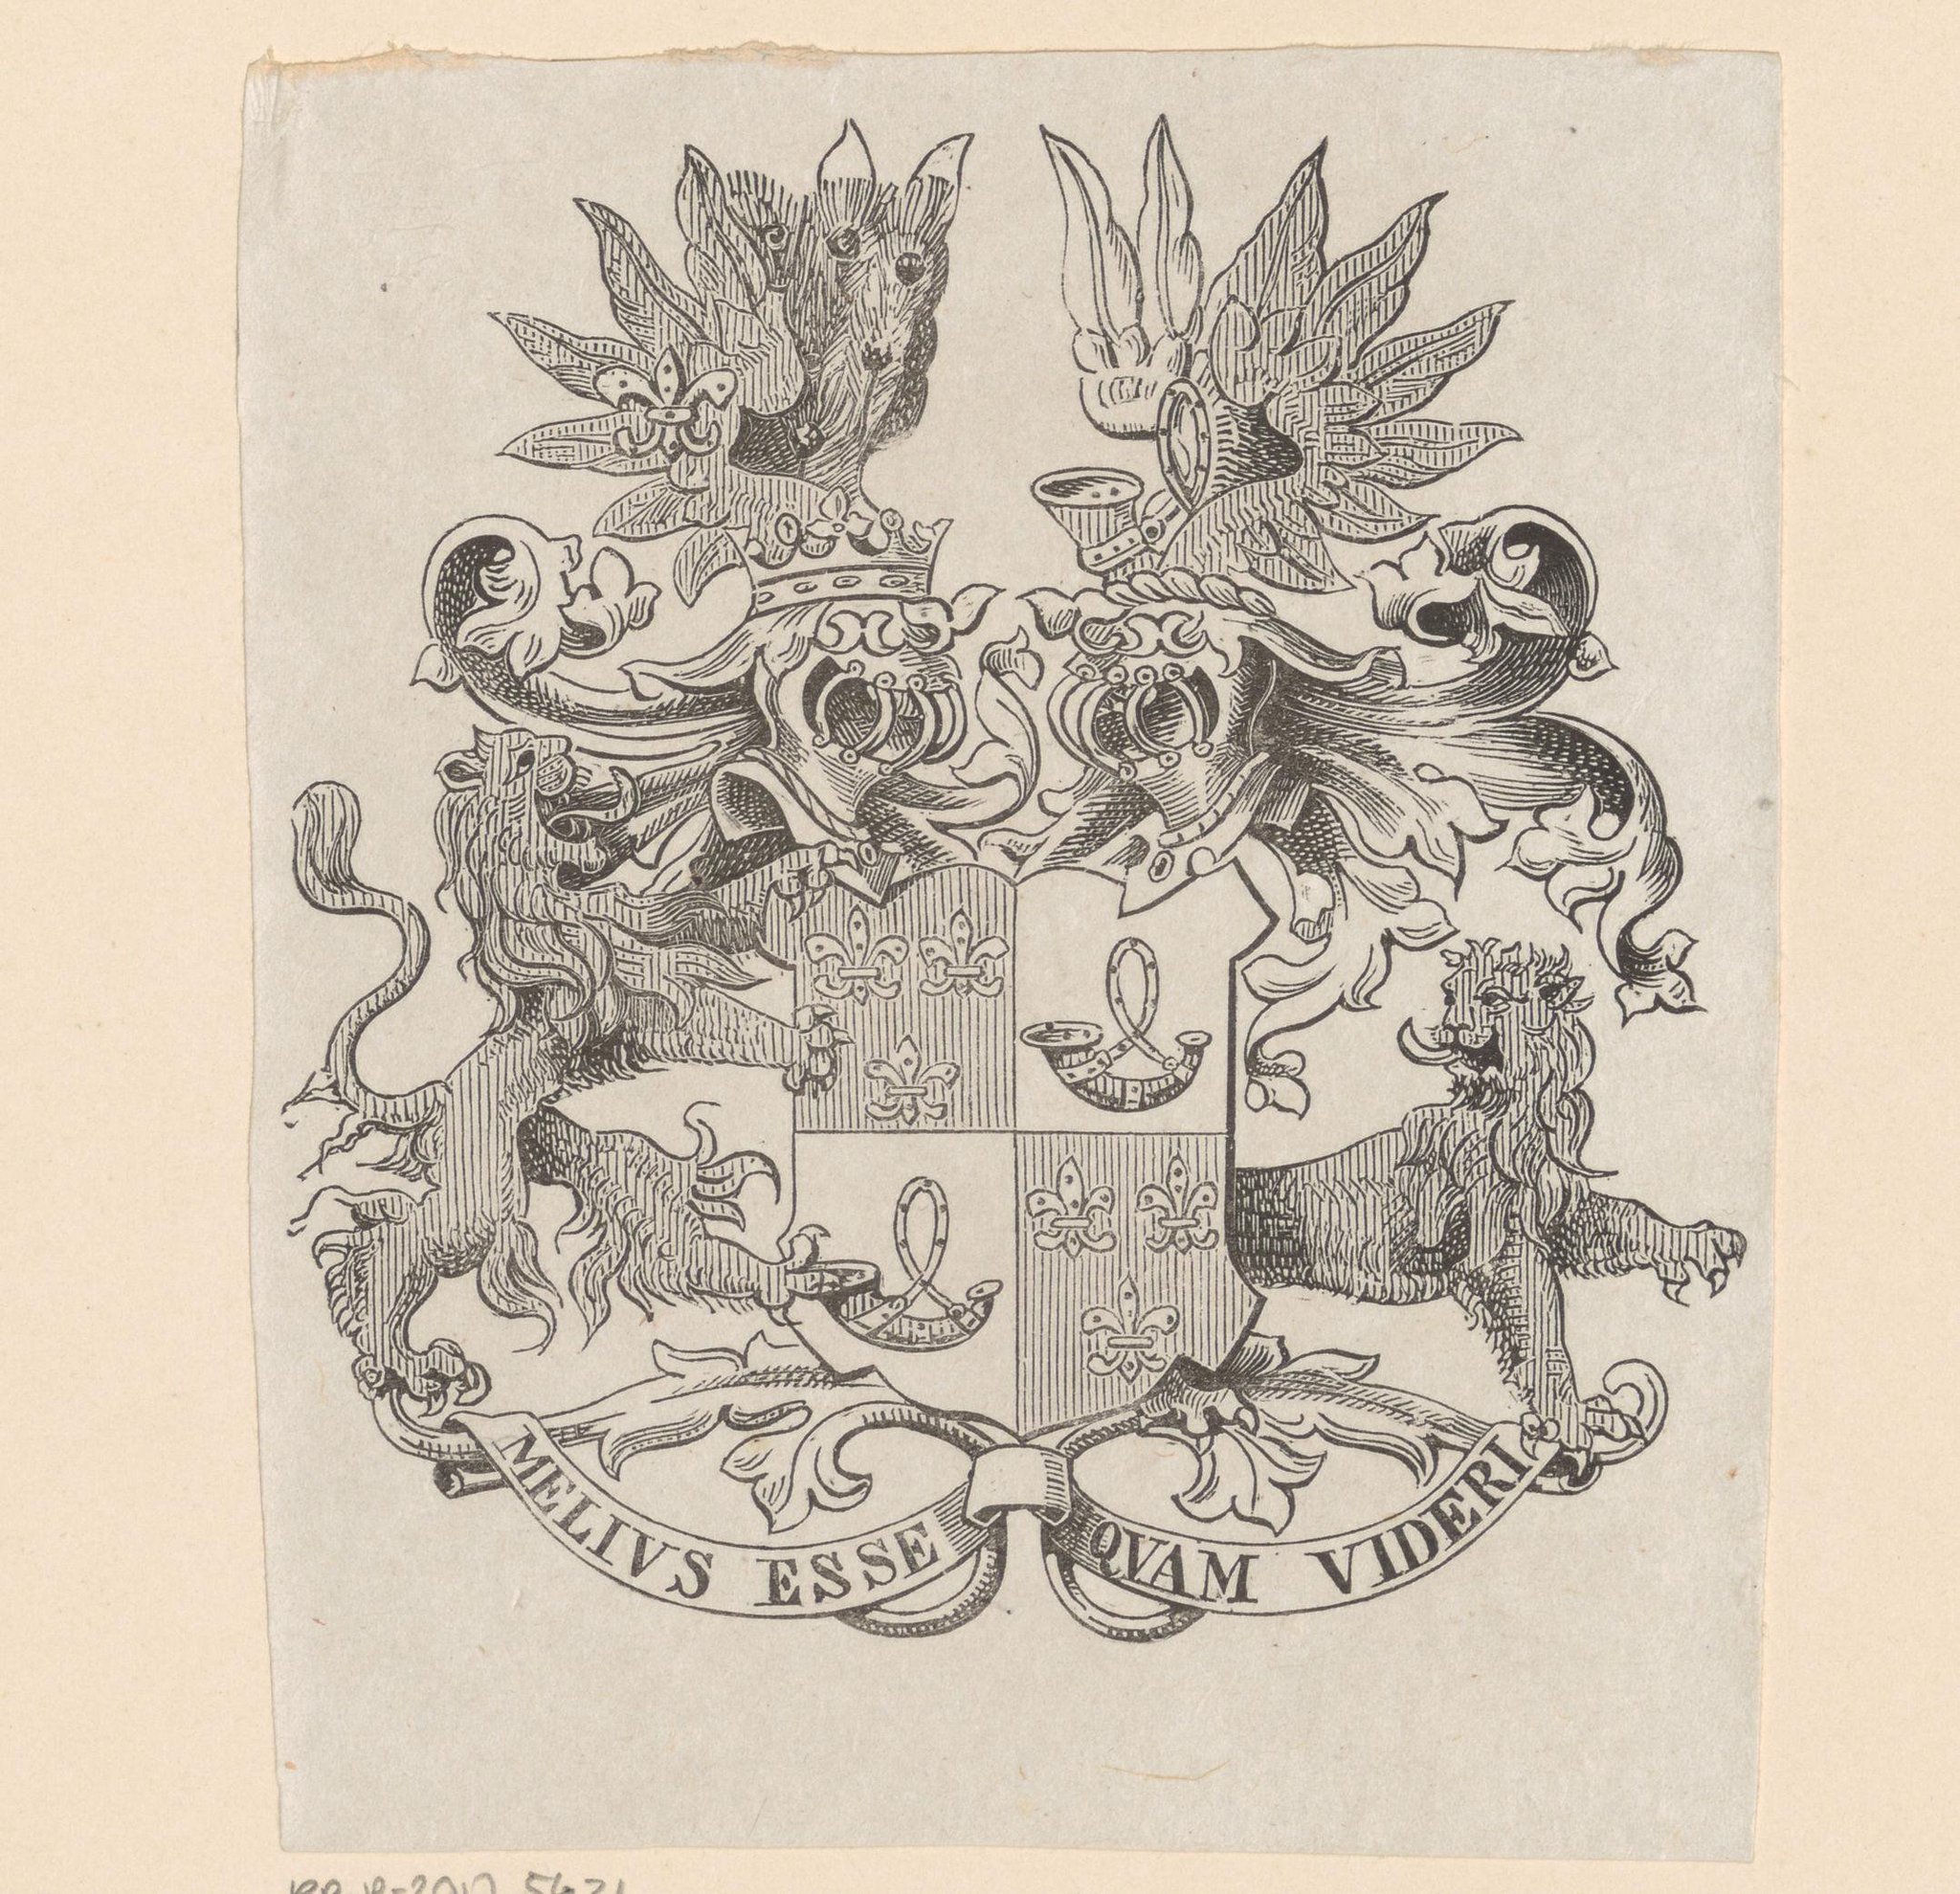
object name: bookplate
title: Ex libris van A.A. Vorsterman van Oyen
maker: Anonymous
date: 1855-1912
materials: paper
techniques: printing block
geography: netherlands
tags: antonie abraham vorsterman van oijen, beasts of prey, predatory animals: lion, armorial bearing, heraldry